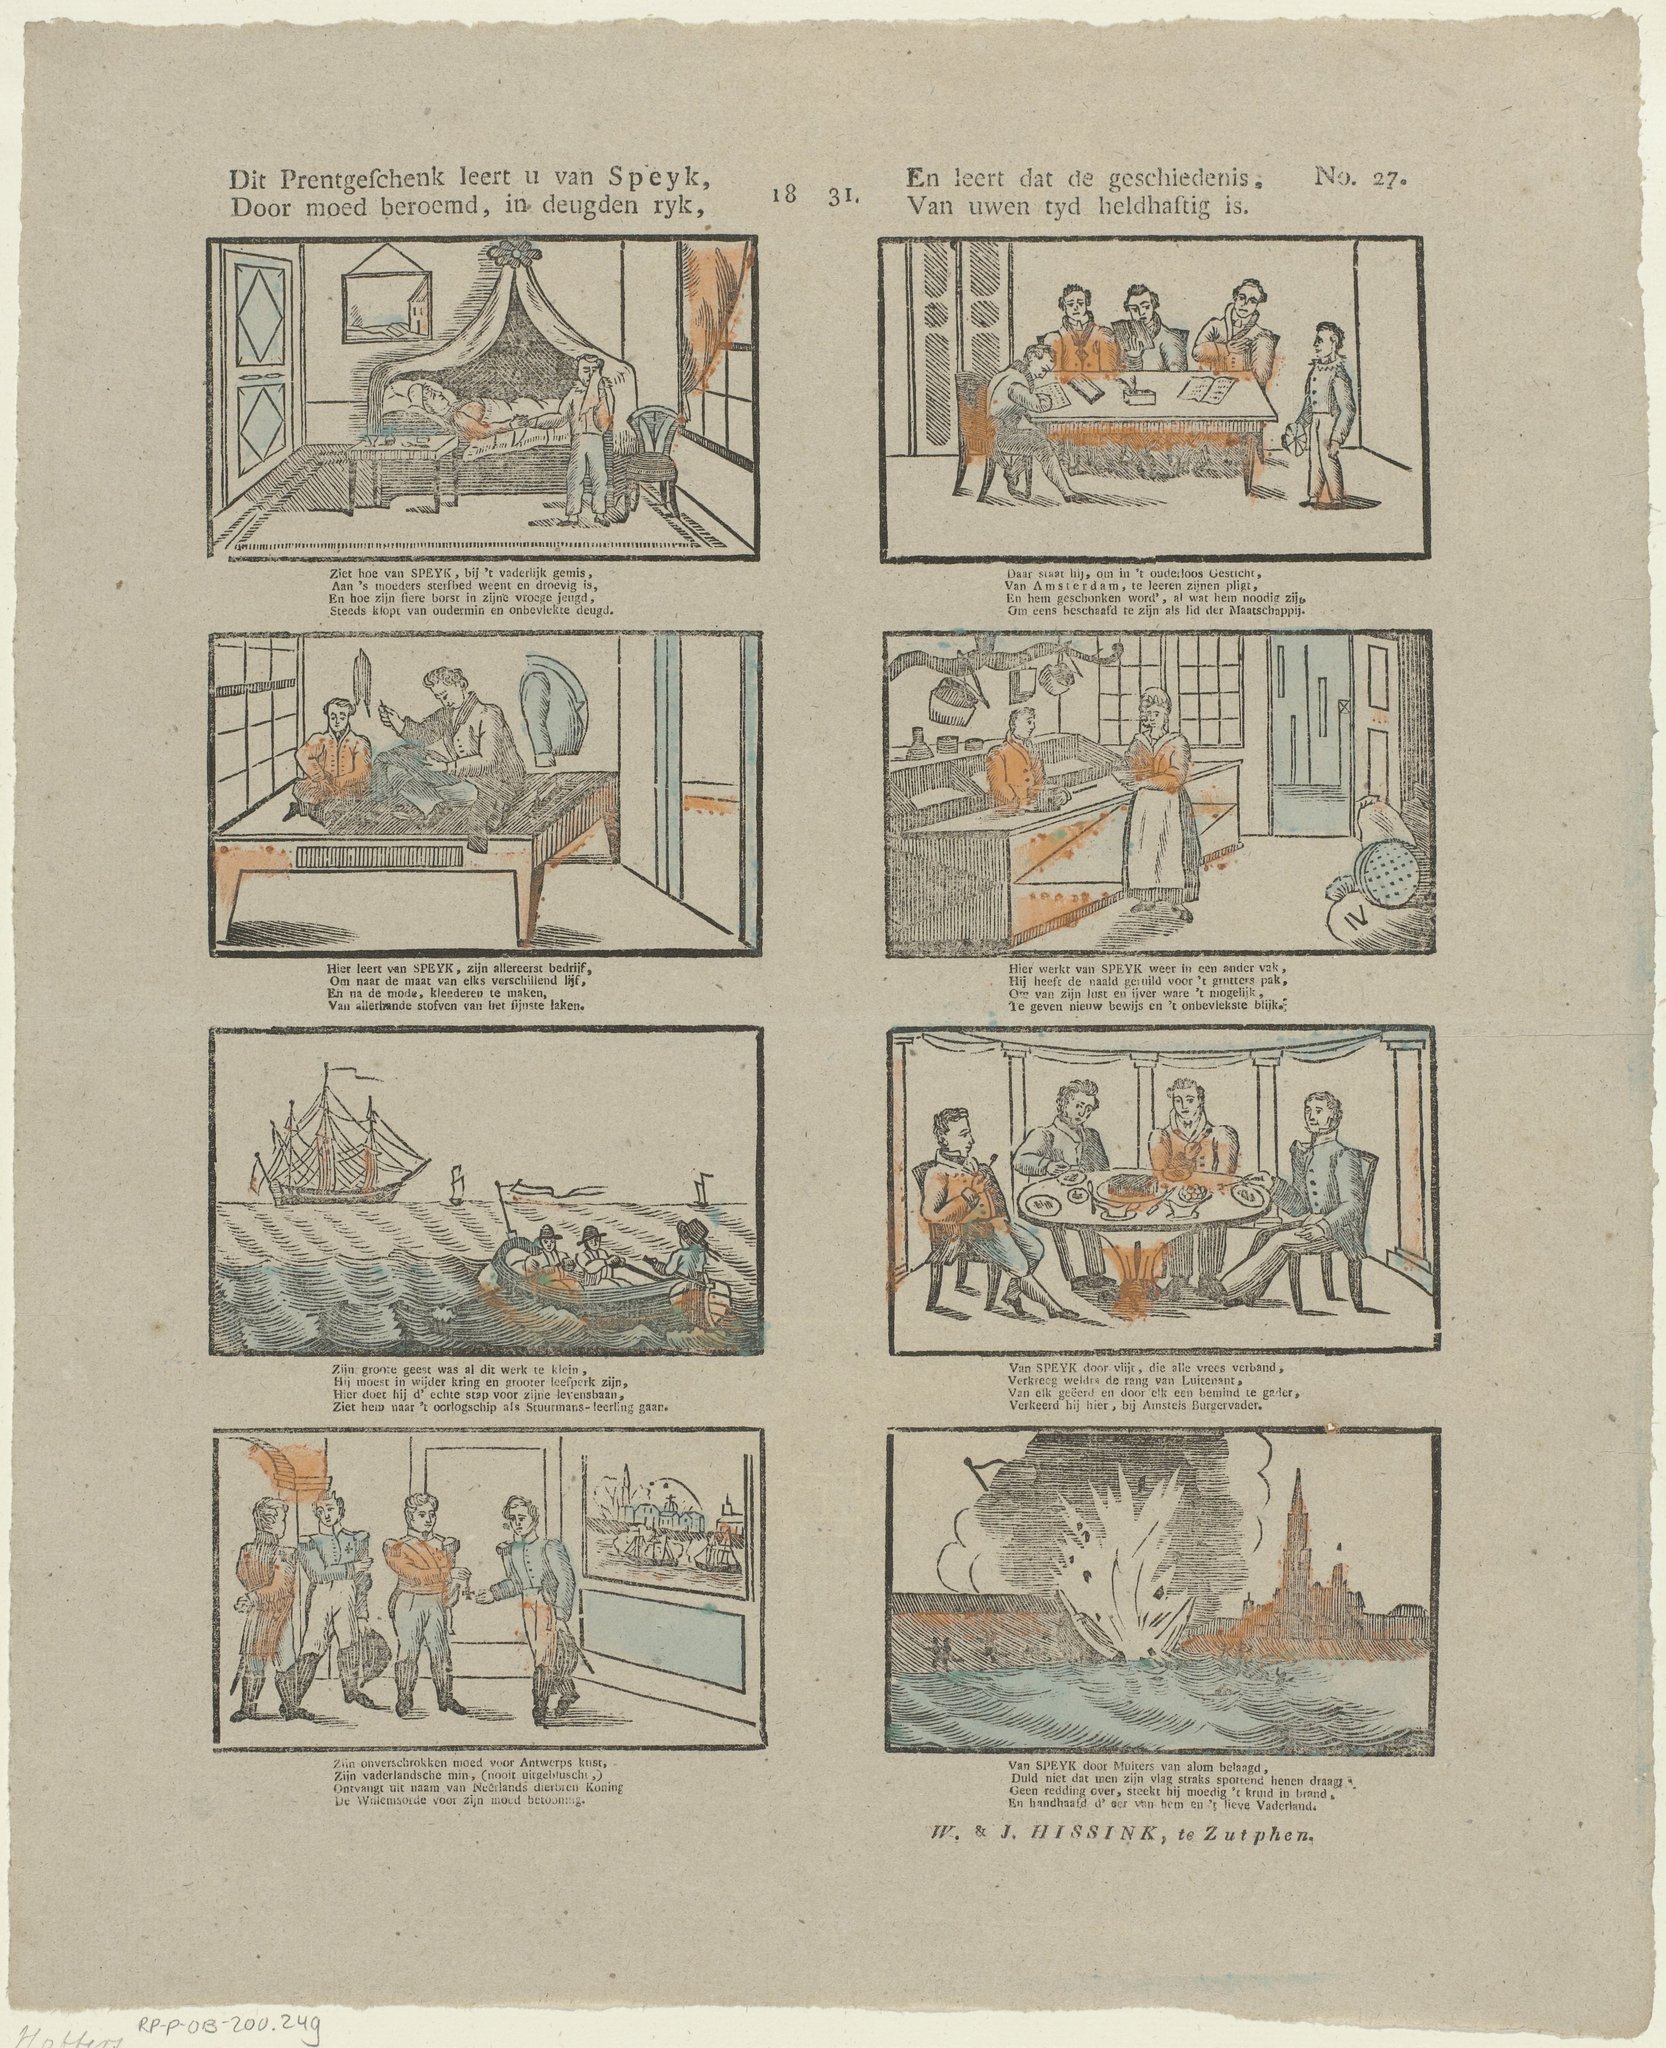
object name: popular print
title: Dit prentgeschenk leert u van Speyk, / Door moed beroemd, in deugden ryk, / En leert dat de geschiedenis, / Van uwen tyd heldhaftig is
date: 1831-1837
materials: paper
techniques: colour, letterpress printing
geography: rotterdam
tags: amsterdam, antwerp, jan van speyk, battle, revolution, revolt, tailor, dressmaker, orphans, netherlands, belgium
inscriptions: collector's mark: Lugt 2760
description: Blad met 8 voorstellingen over het leven en de zelfopoffering van J.C.J. van Speyk tijdens de strijd tegen de Belgen. Onder elke afbeelding een vierregelig vers. Genummerd rechtsboven: No. 27.